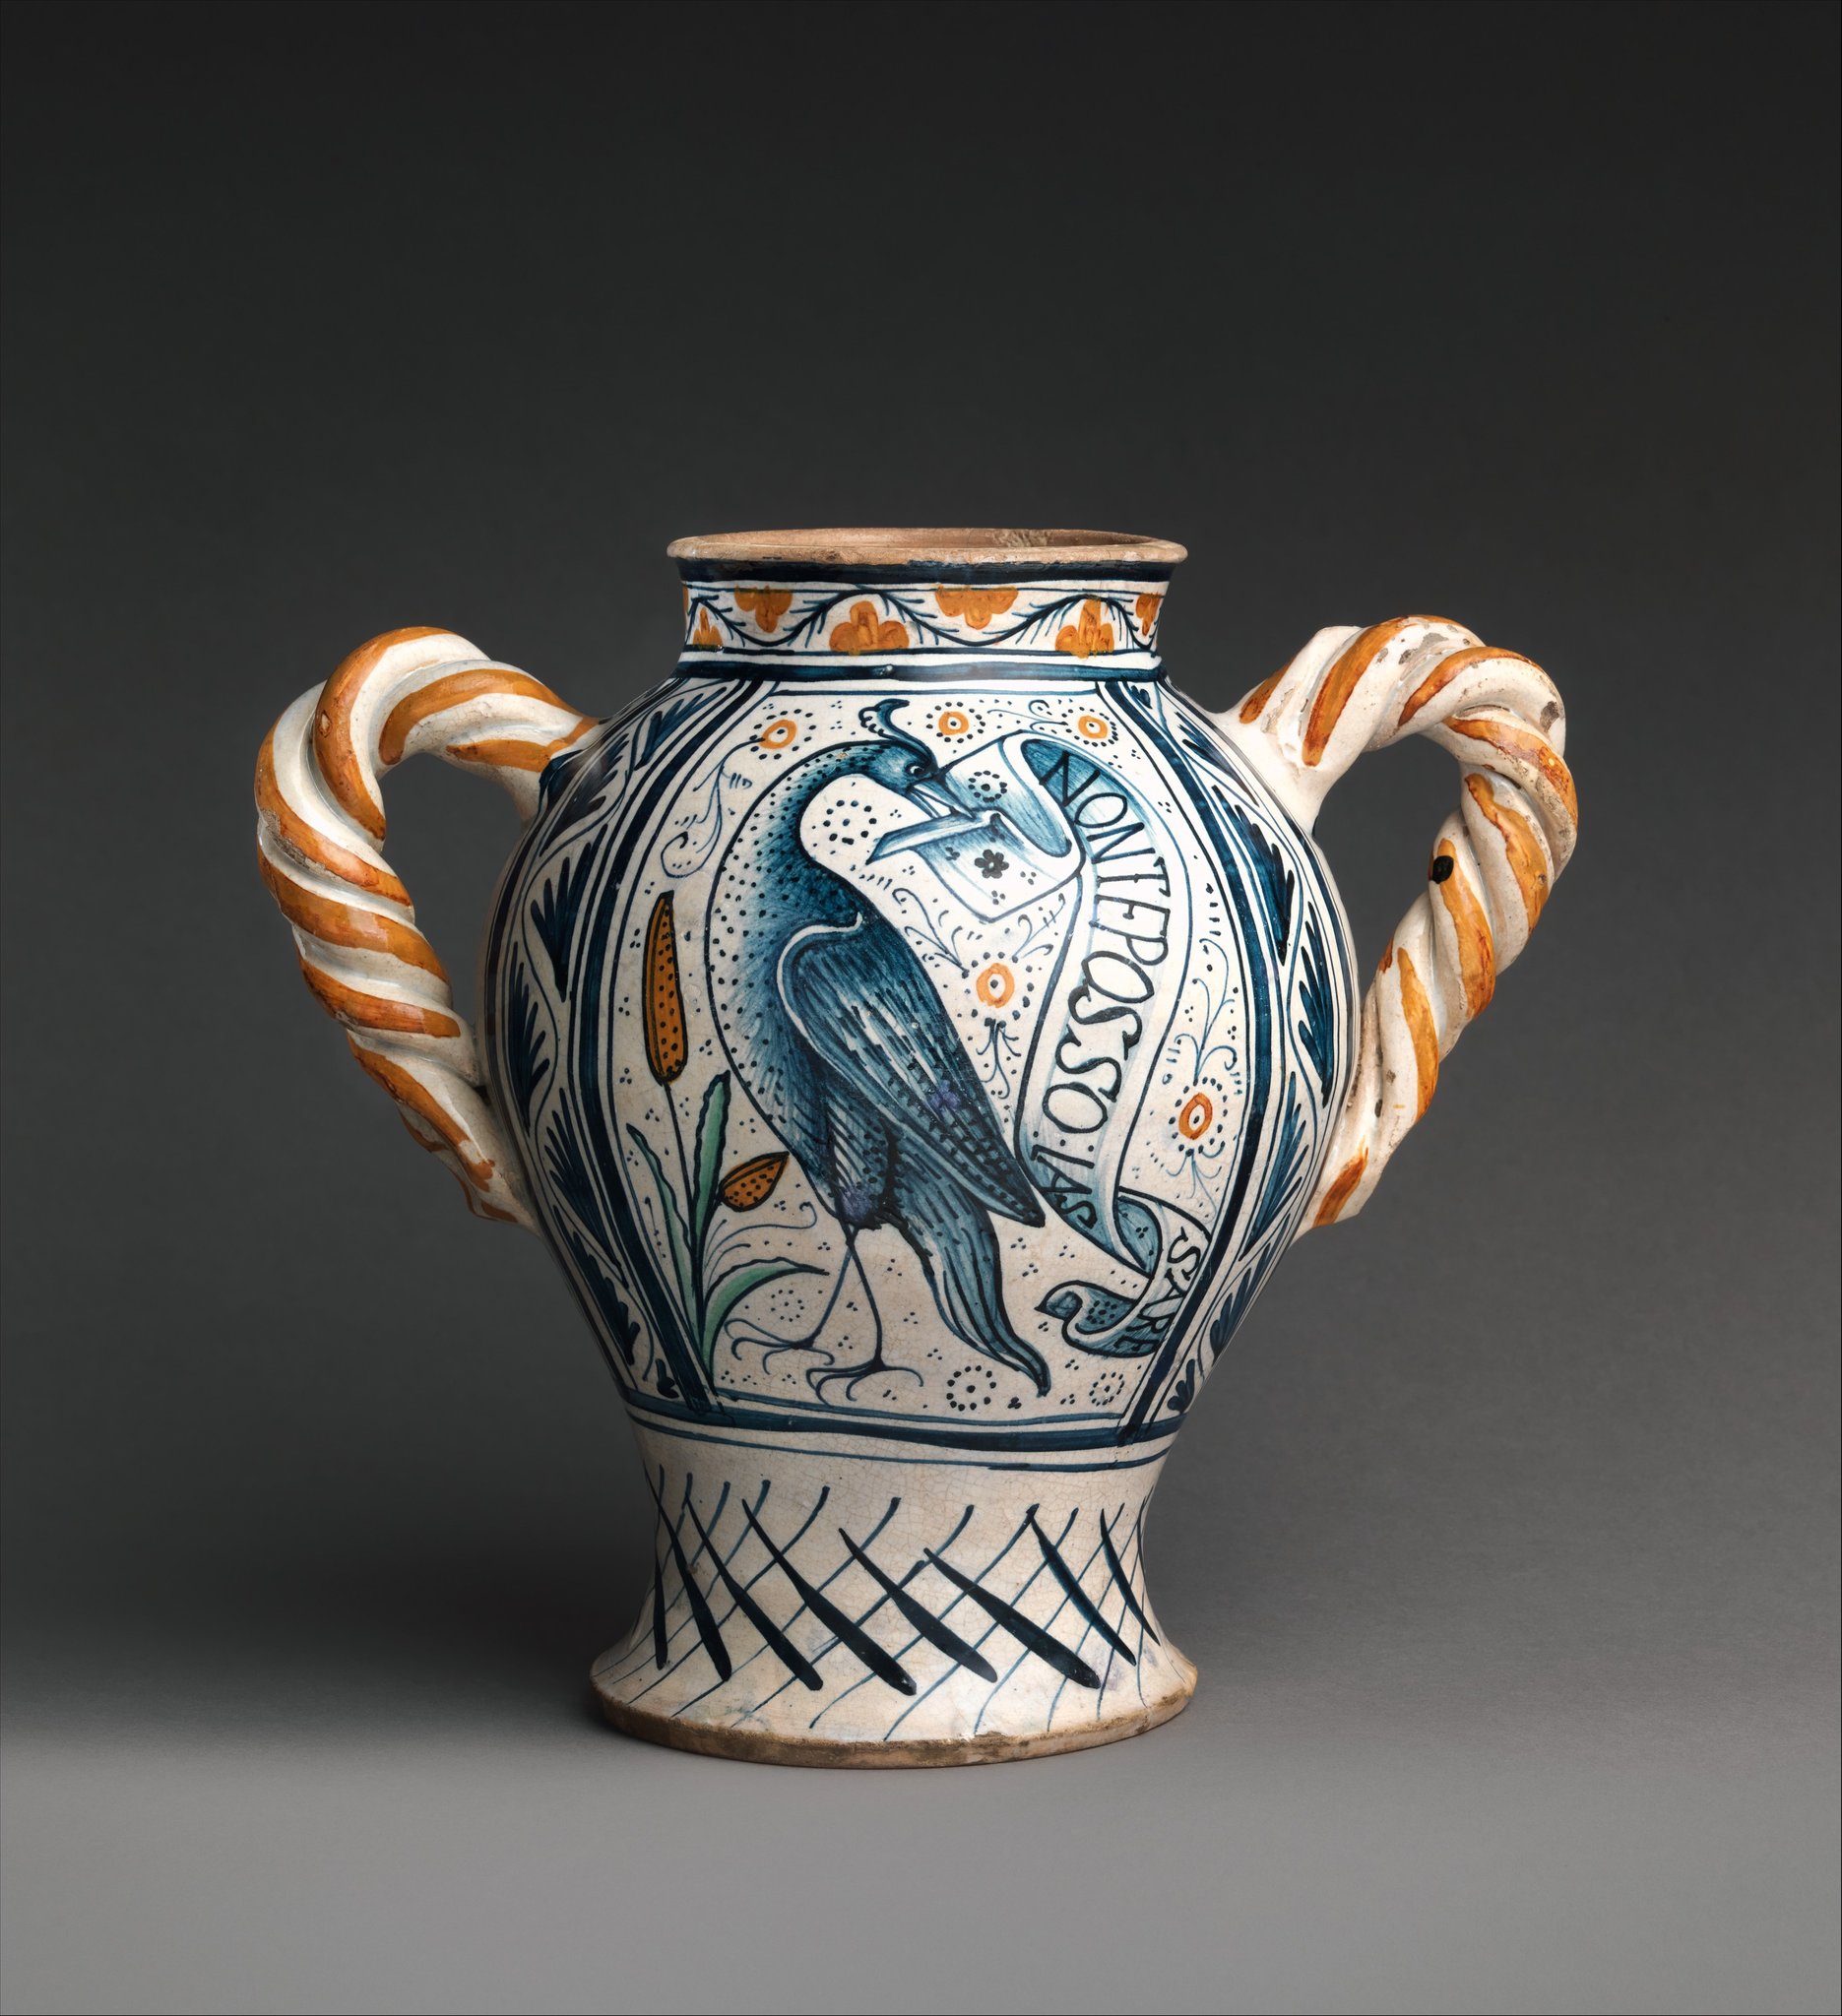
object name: vase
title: Vase with love motifs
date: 1470-1490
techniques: maiolica, glazing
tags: birds,scrolls